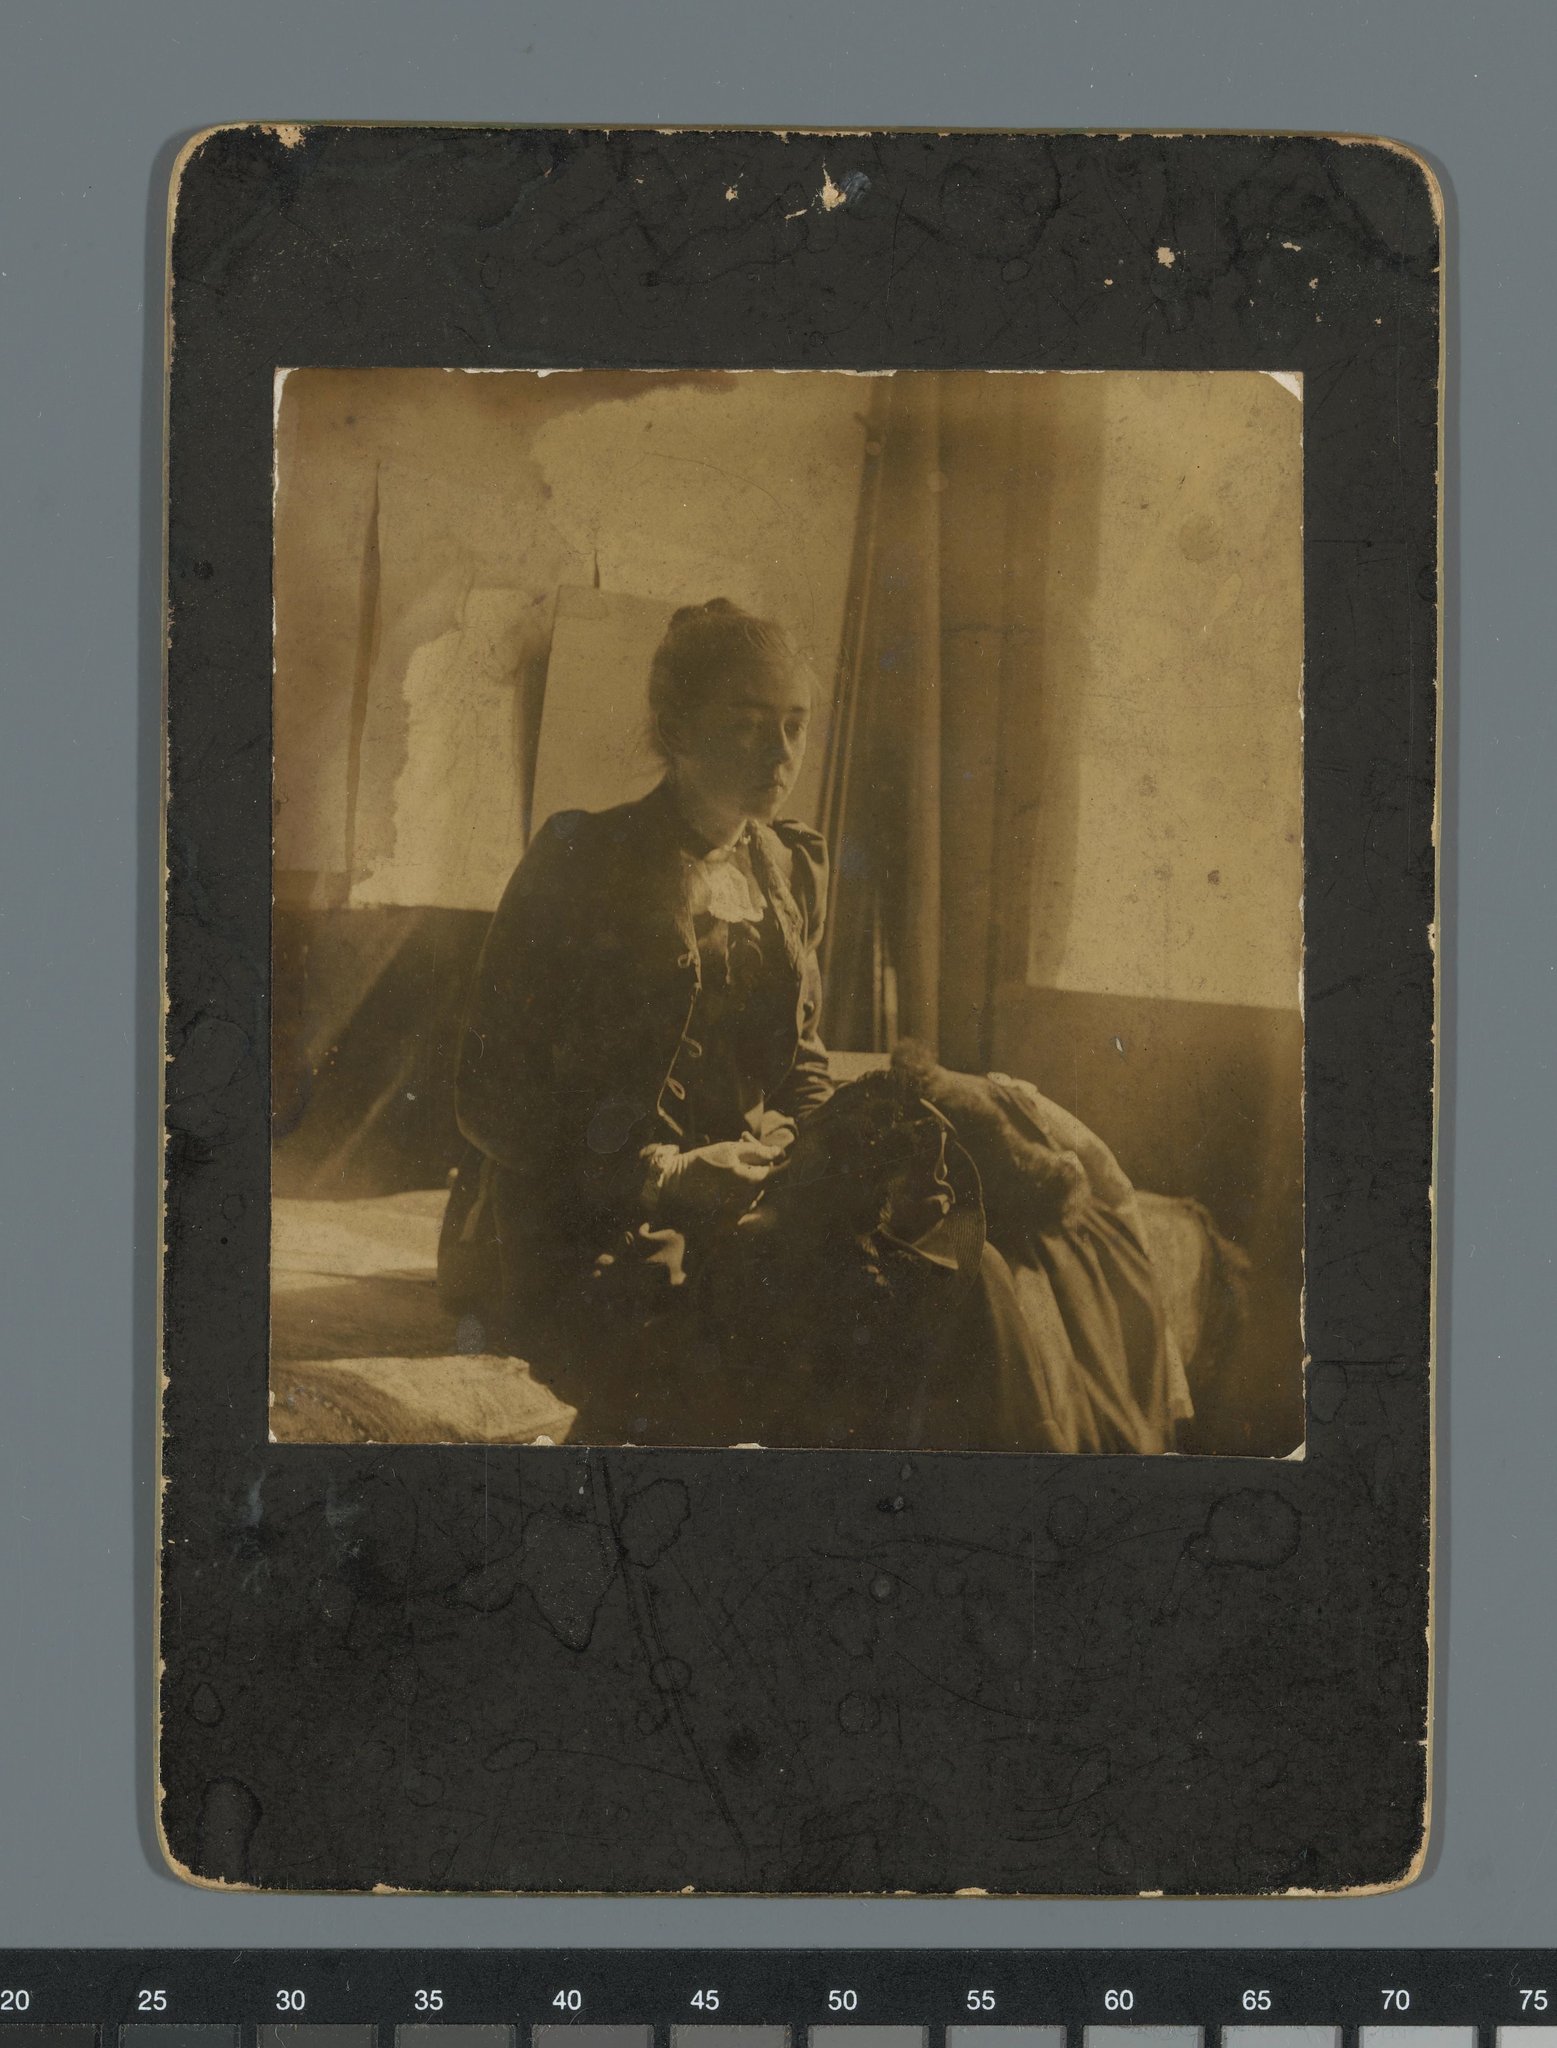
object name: photograph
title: Portret van (de schilderes) Lizzy Ansingh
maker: george hendrik breitner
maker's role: draughtsman, painter, print maker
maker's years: 1857-1923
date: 1894-1895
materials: cardboard, paper, photographic support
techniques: gelatin silver print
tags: lizzy ansingh, historical persons - bb - woman, portrait, self-portrait of painter, workshop-interior, amsterdam